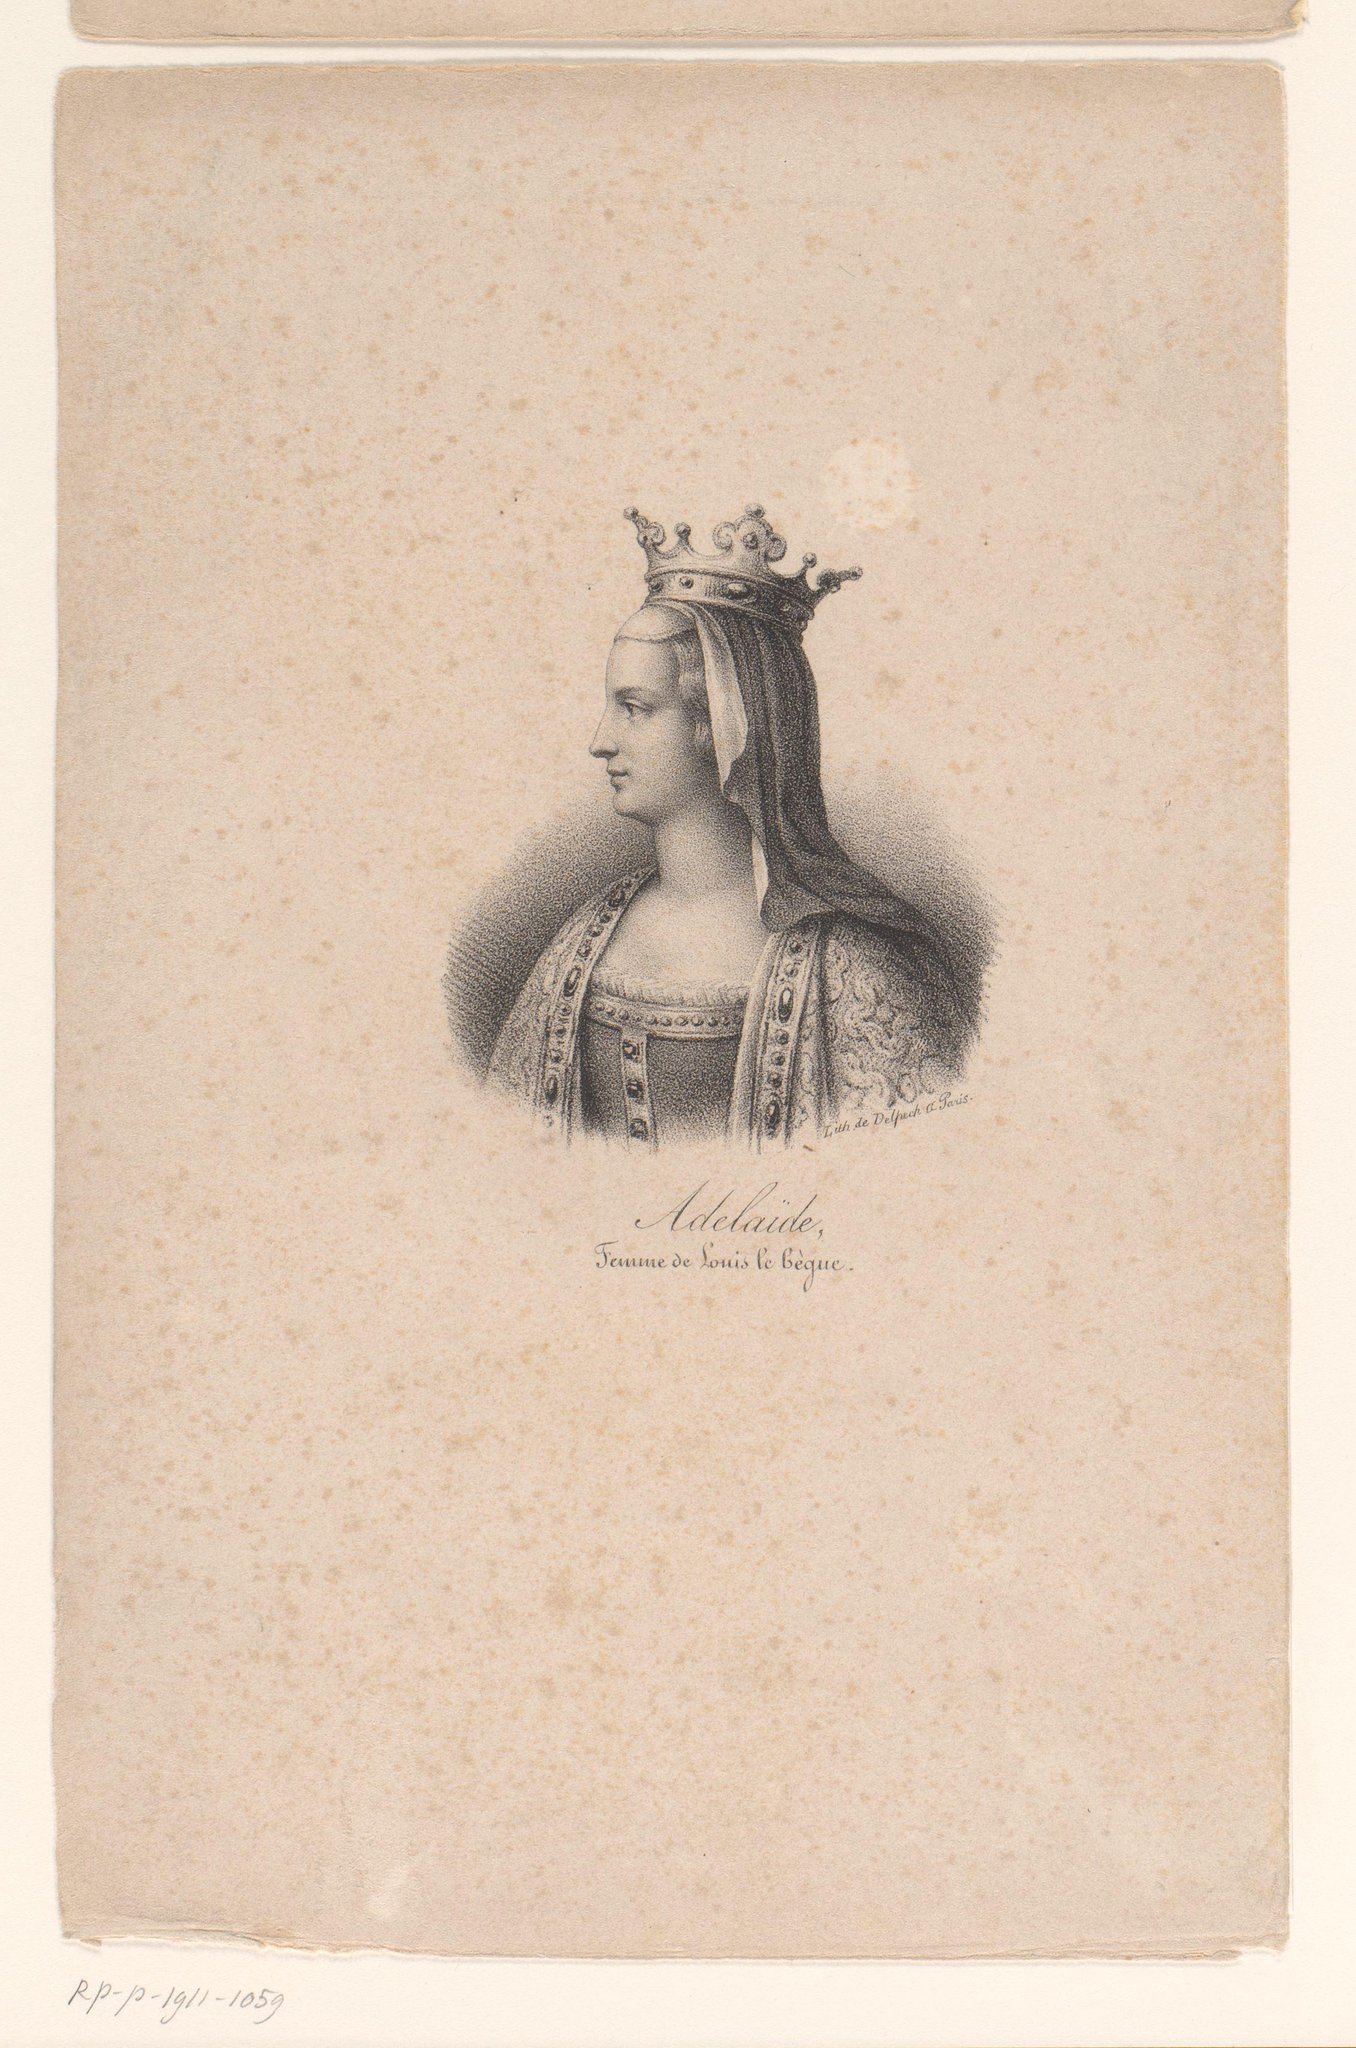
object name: print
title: Portret van Adelheid van Parijs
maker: Anonymous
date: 1818-1842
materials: paper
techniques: lithograph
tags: historical persons - bb - woman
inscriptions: collector's mark: Lugt 2228